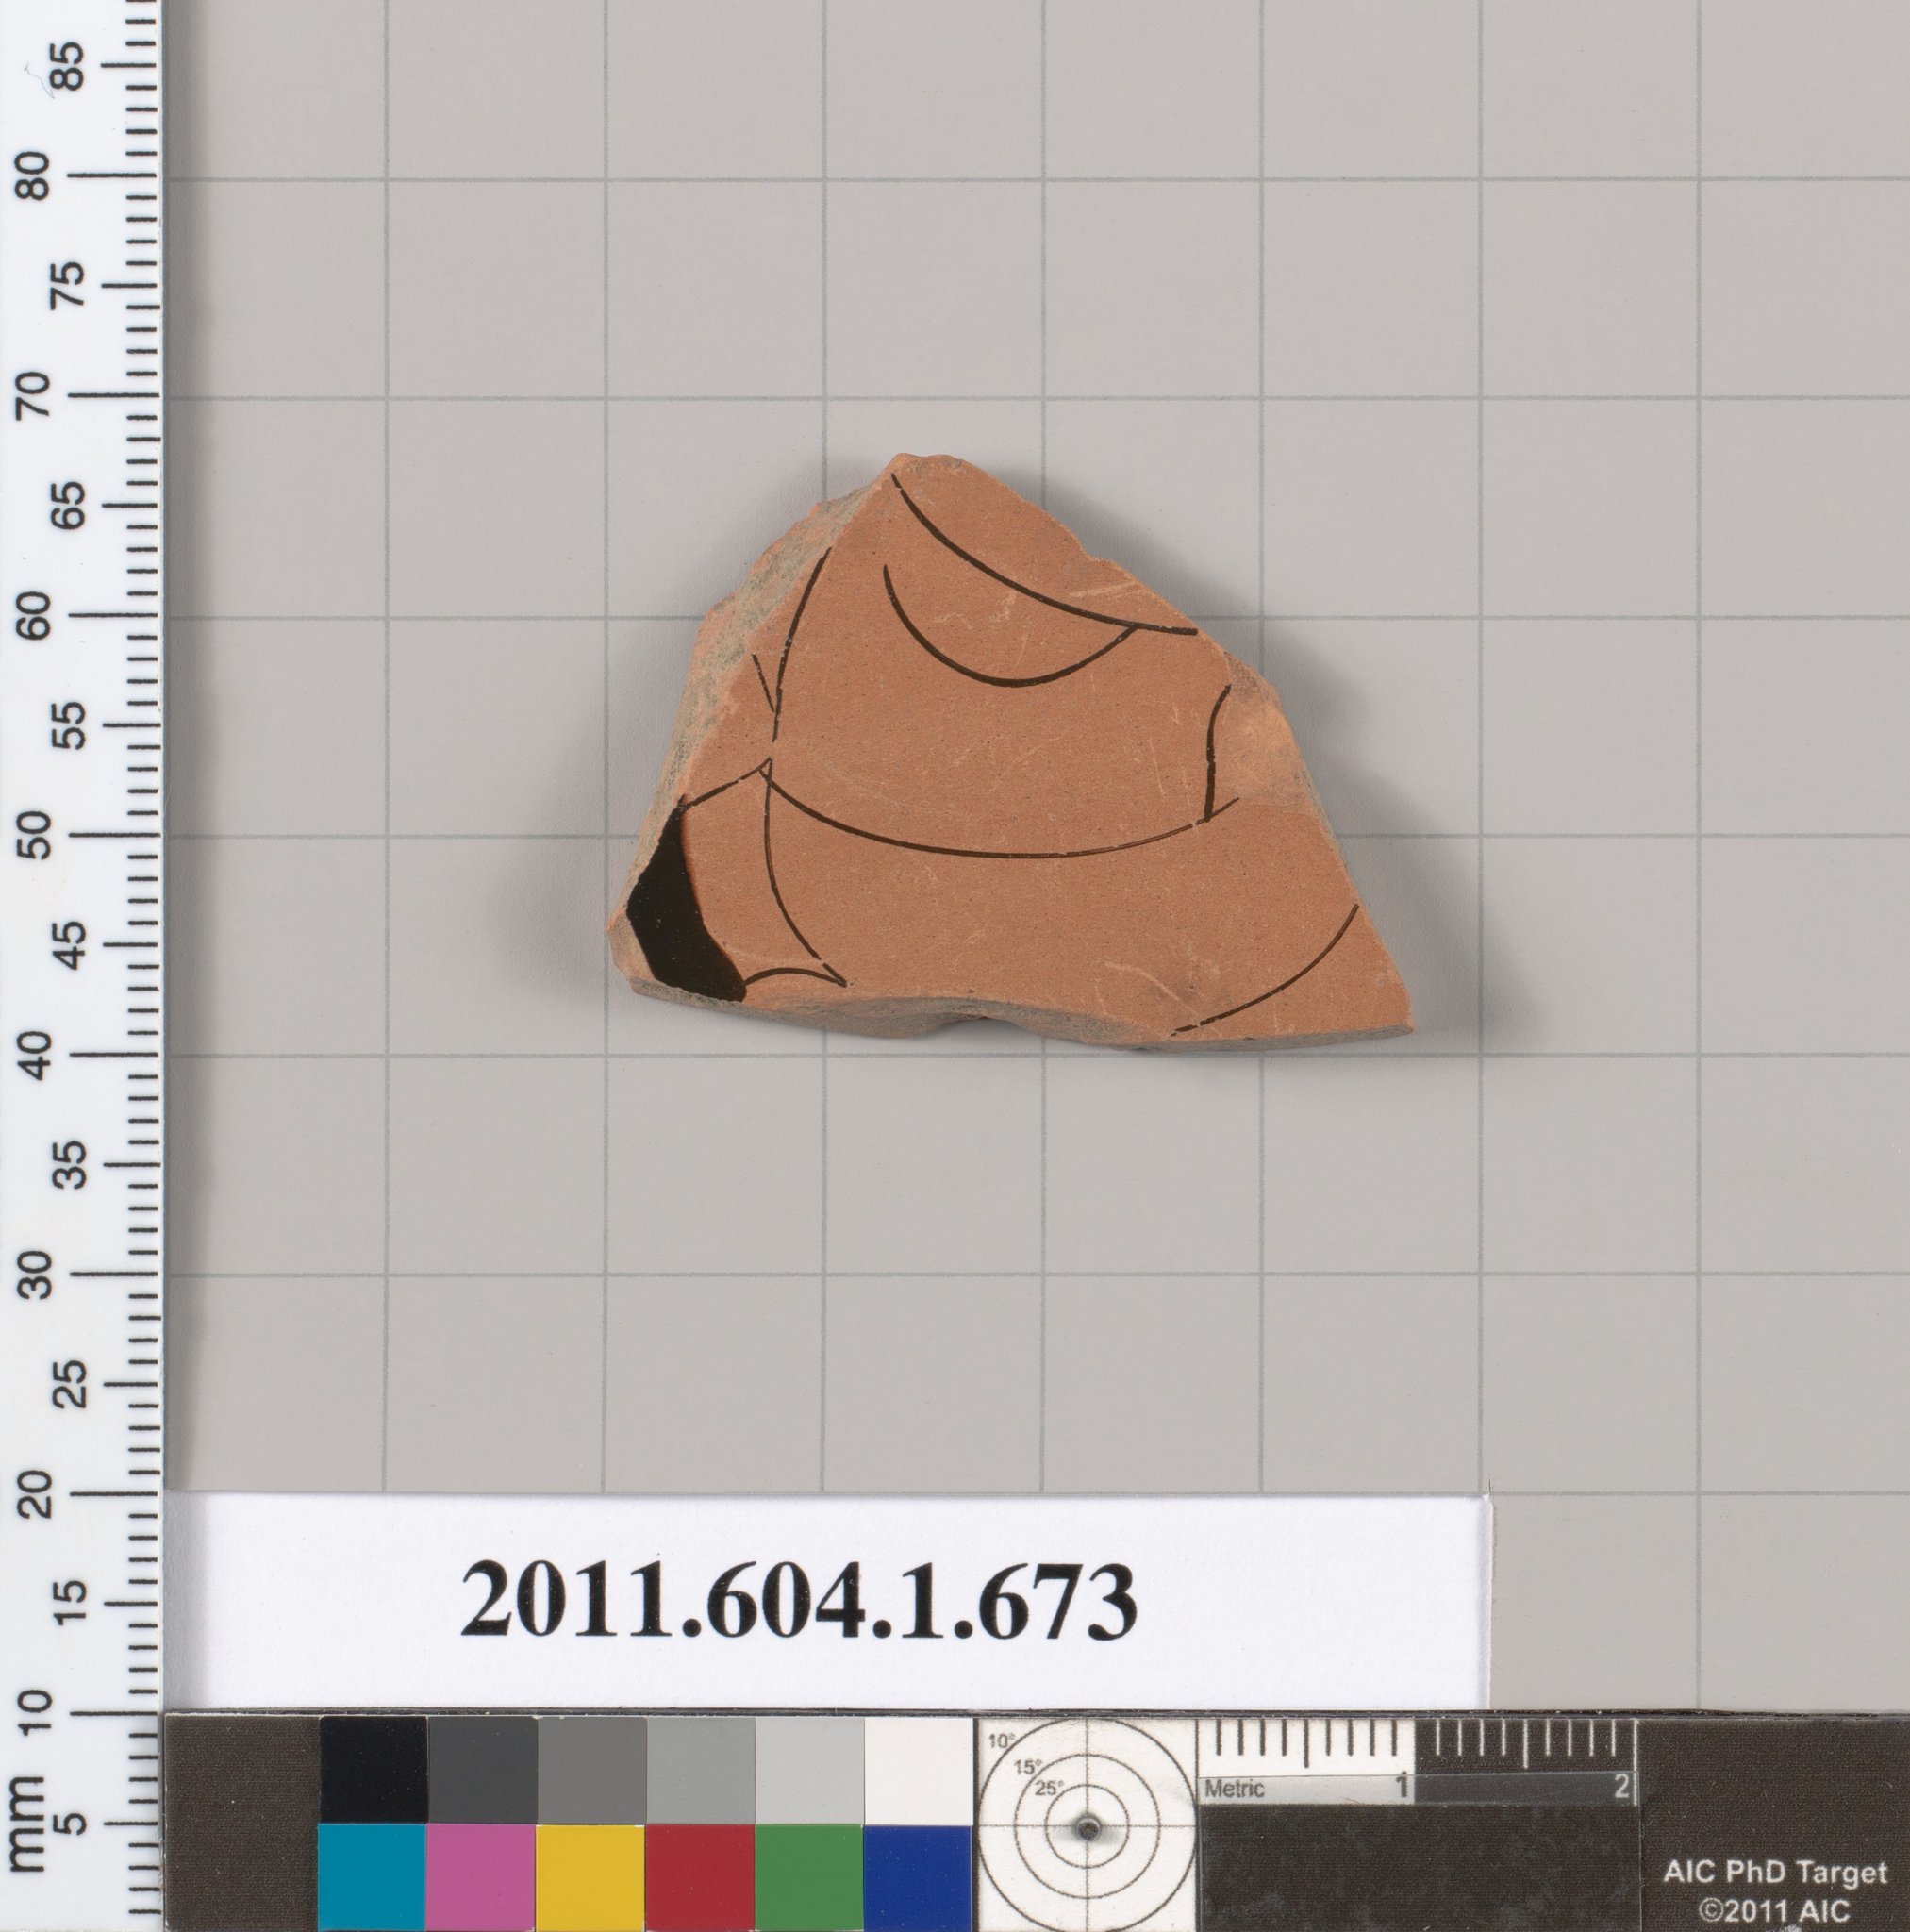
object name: kylix fragment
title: Terracotta fragment of a kylix (drinking cup)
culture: greek, attic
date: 475-451 BCE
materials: terracotta